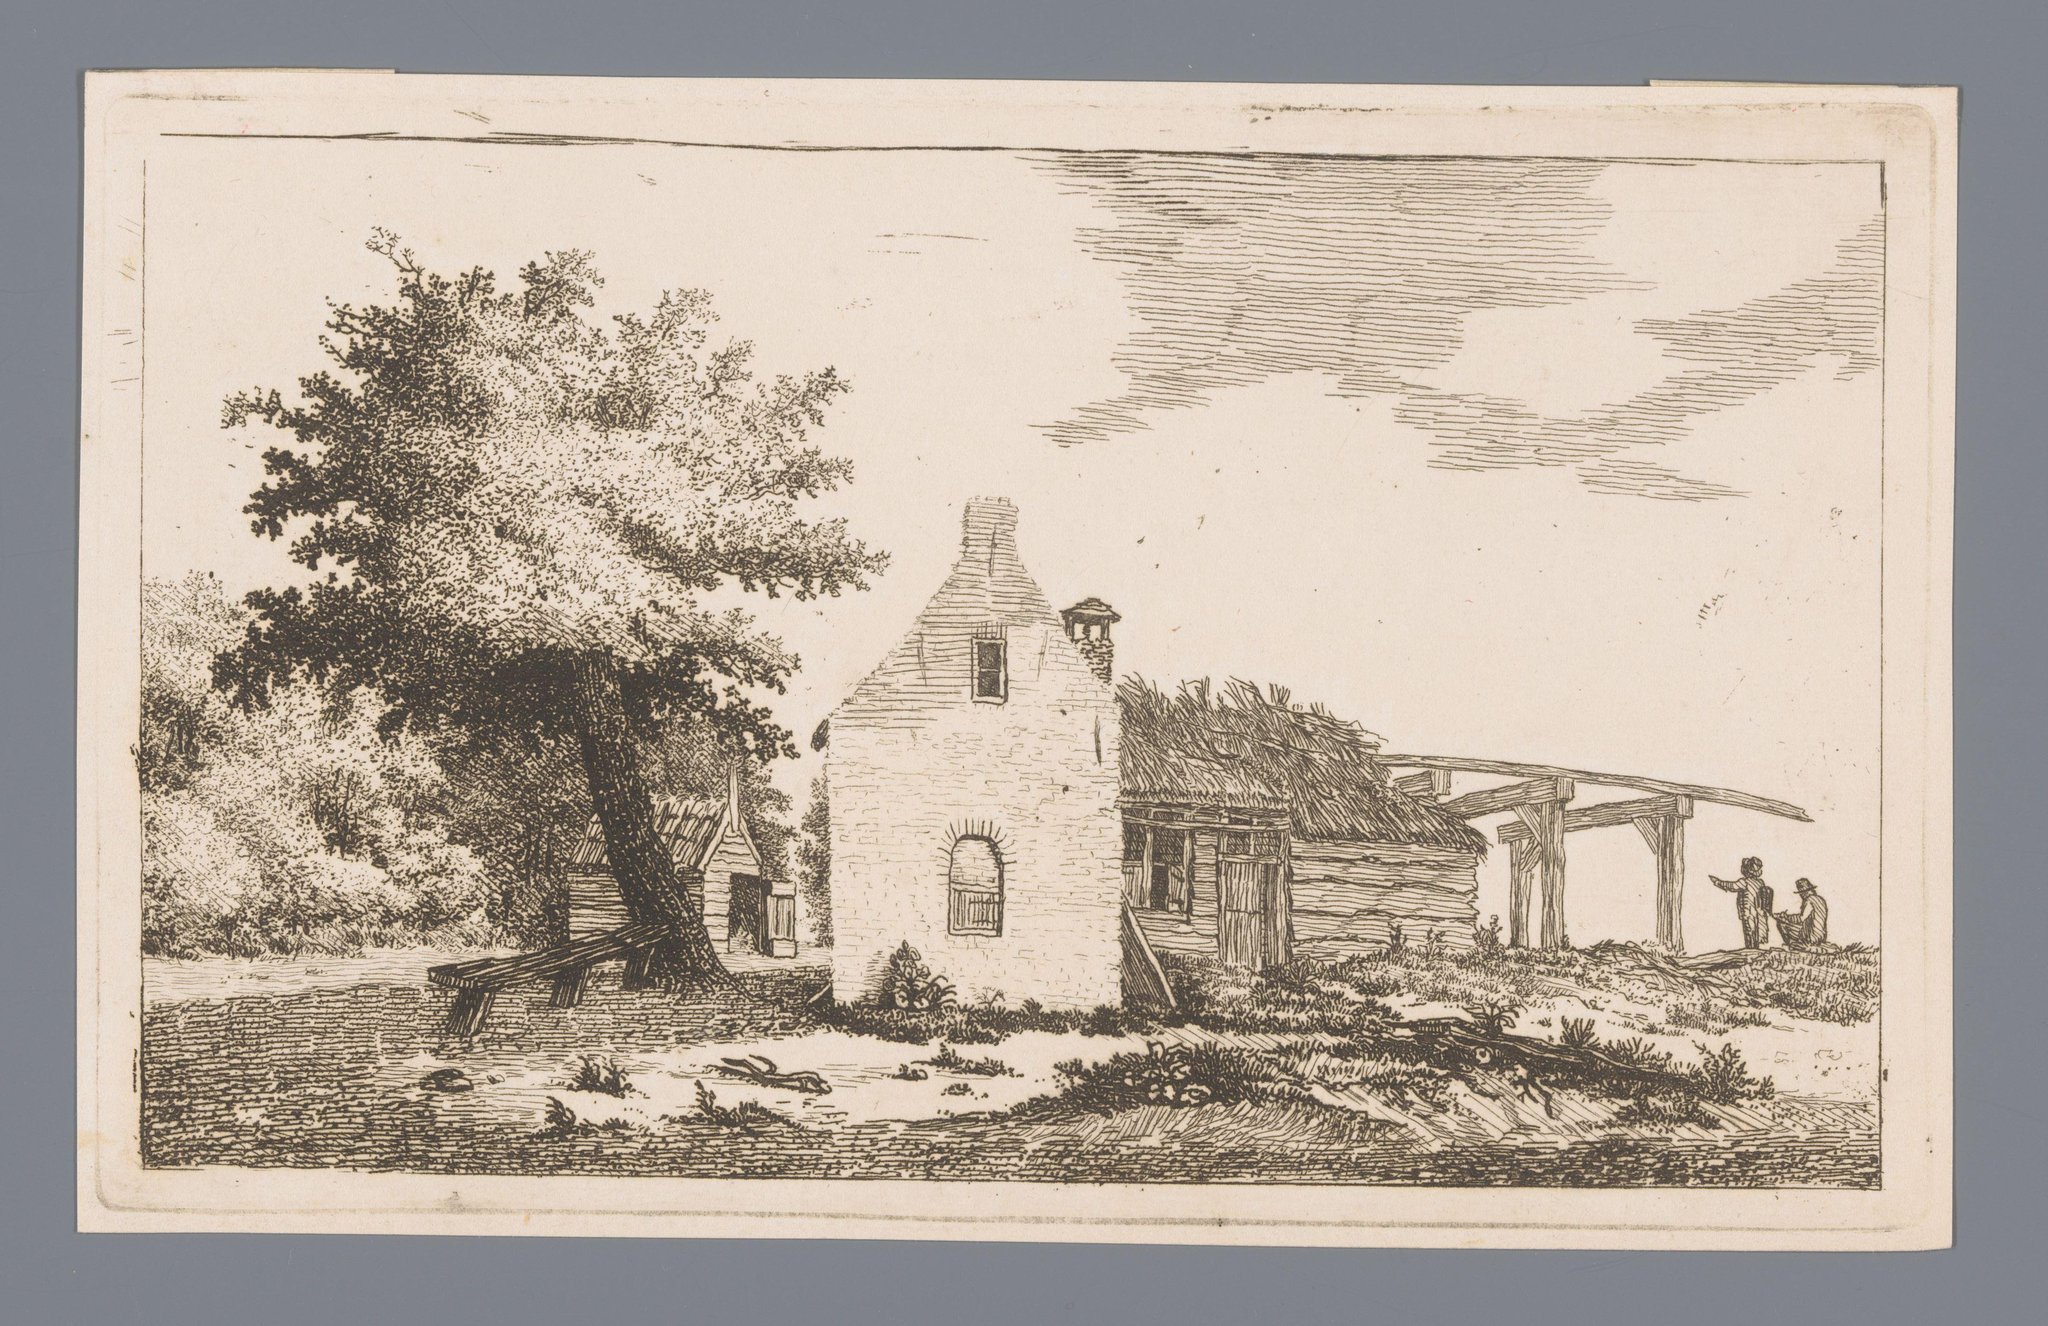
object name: print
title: Ruïne van herberg het Molentje aan de Amstel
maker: anthonie van den bos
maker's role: draughtsman, print maker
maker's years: 1763-1838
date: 1811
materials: paper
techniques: etching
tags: inn, coffee-house, public house, etc., hotel, hostelry, inn, ruin of a dwelling, house, castle, etc.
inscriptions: collector's mark: Lugt 2233